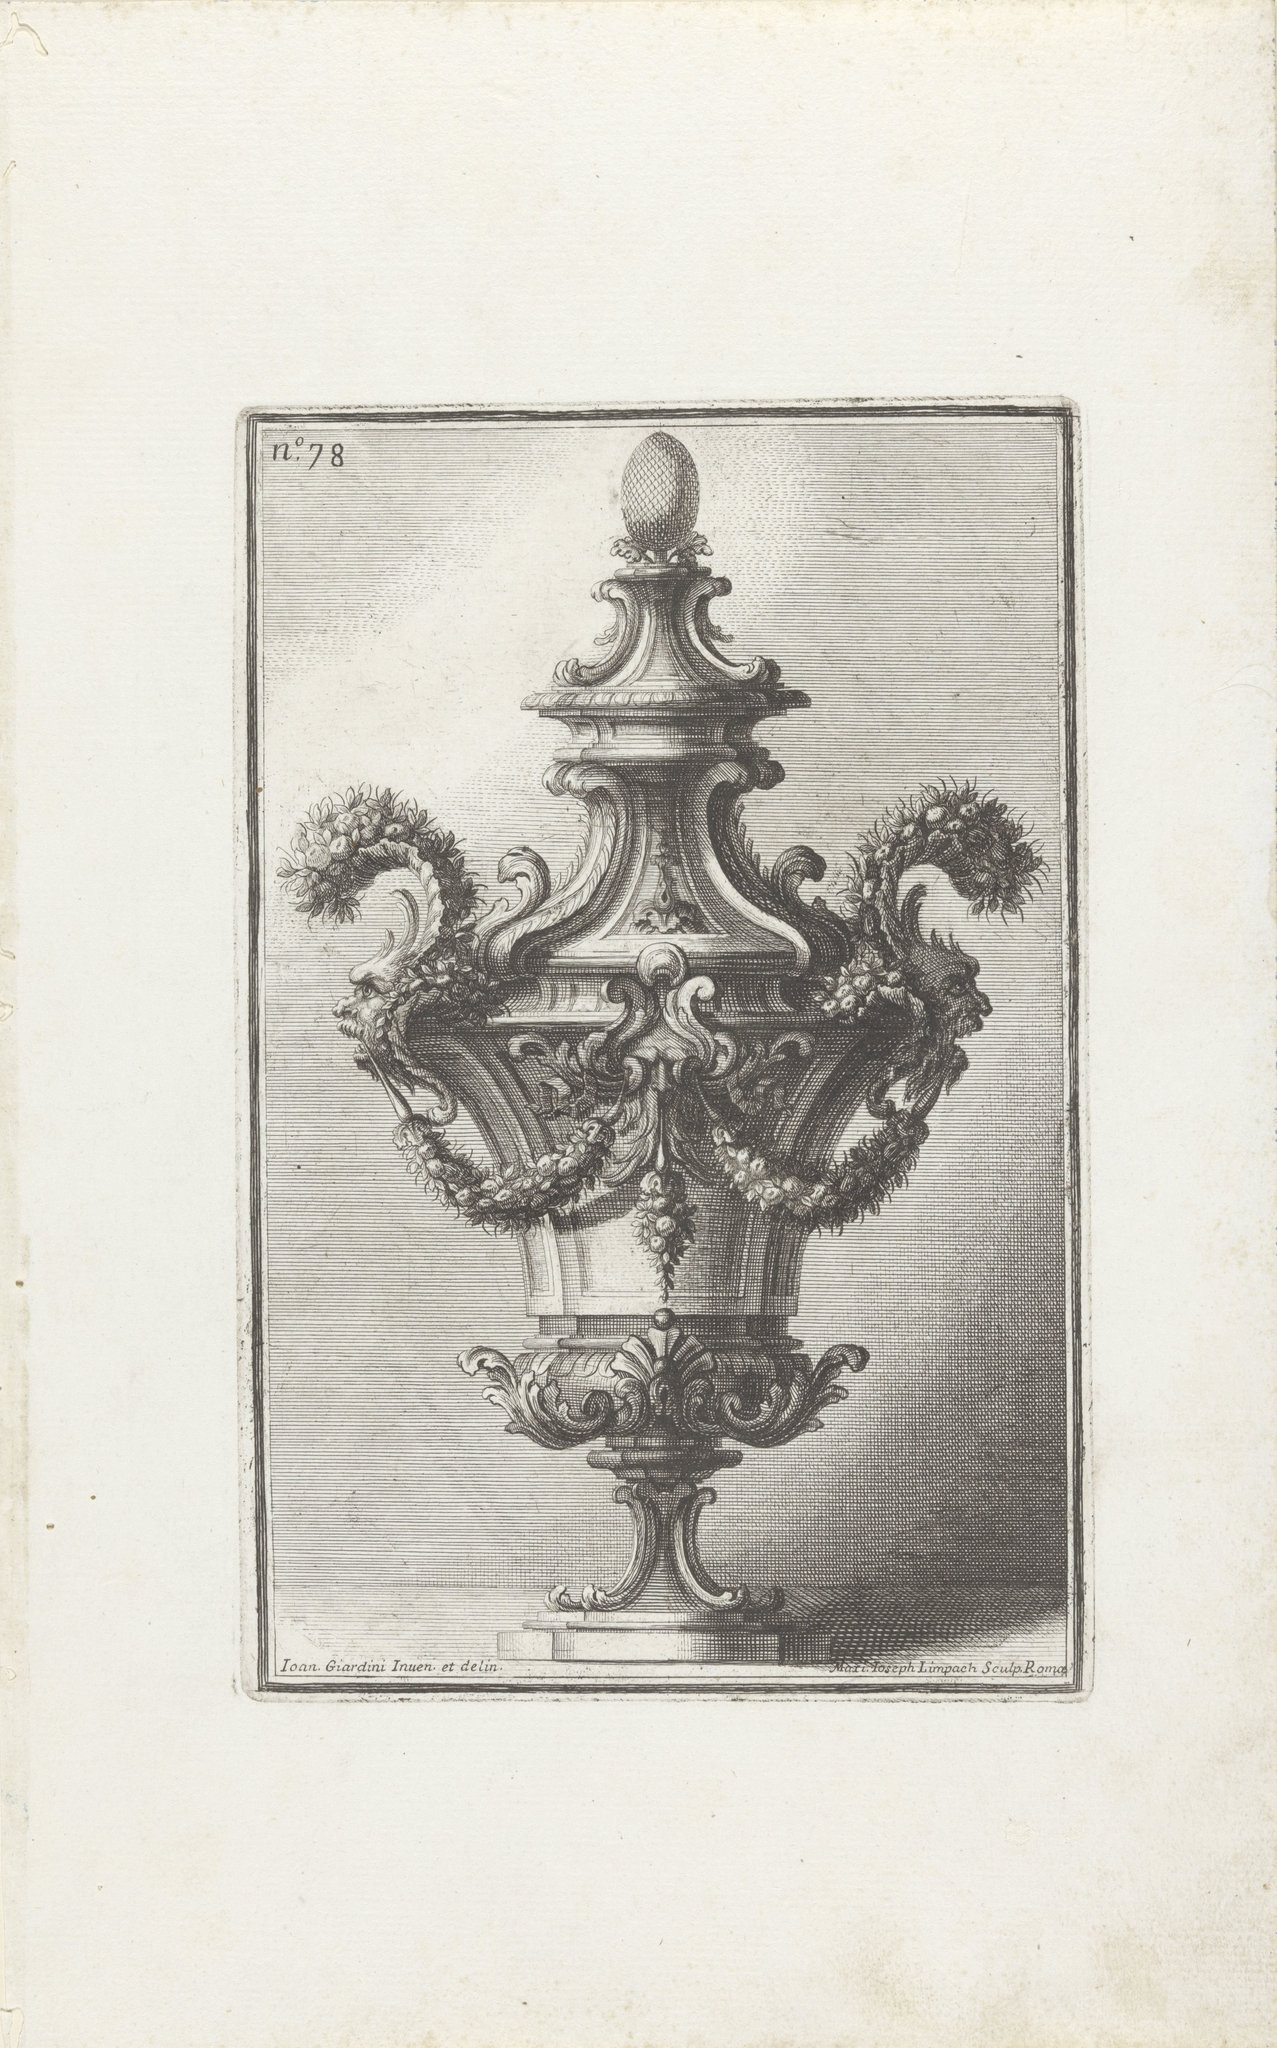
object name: print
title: Diverse kerkelijke voorwerpen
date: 1714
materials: paper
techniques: etching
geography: italy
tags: ornament ~ grotesque, vase ~ ornament, ornament ~ festoon, garland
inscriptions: collector's mark: Lugt 2228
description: Prent maakt deel uit van een reeks van 100 ornamentprenten naar ontwerp van Giovanni Giardini.